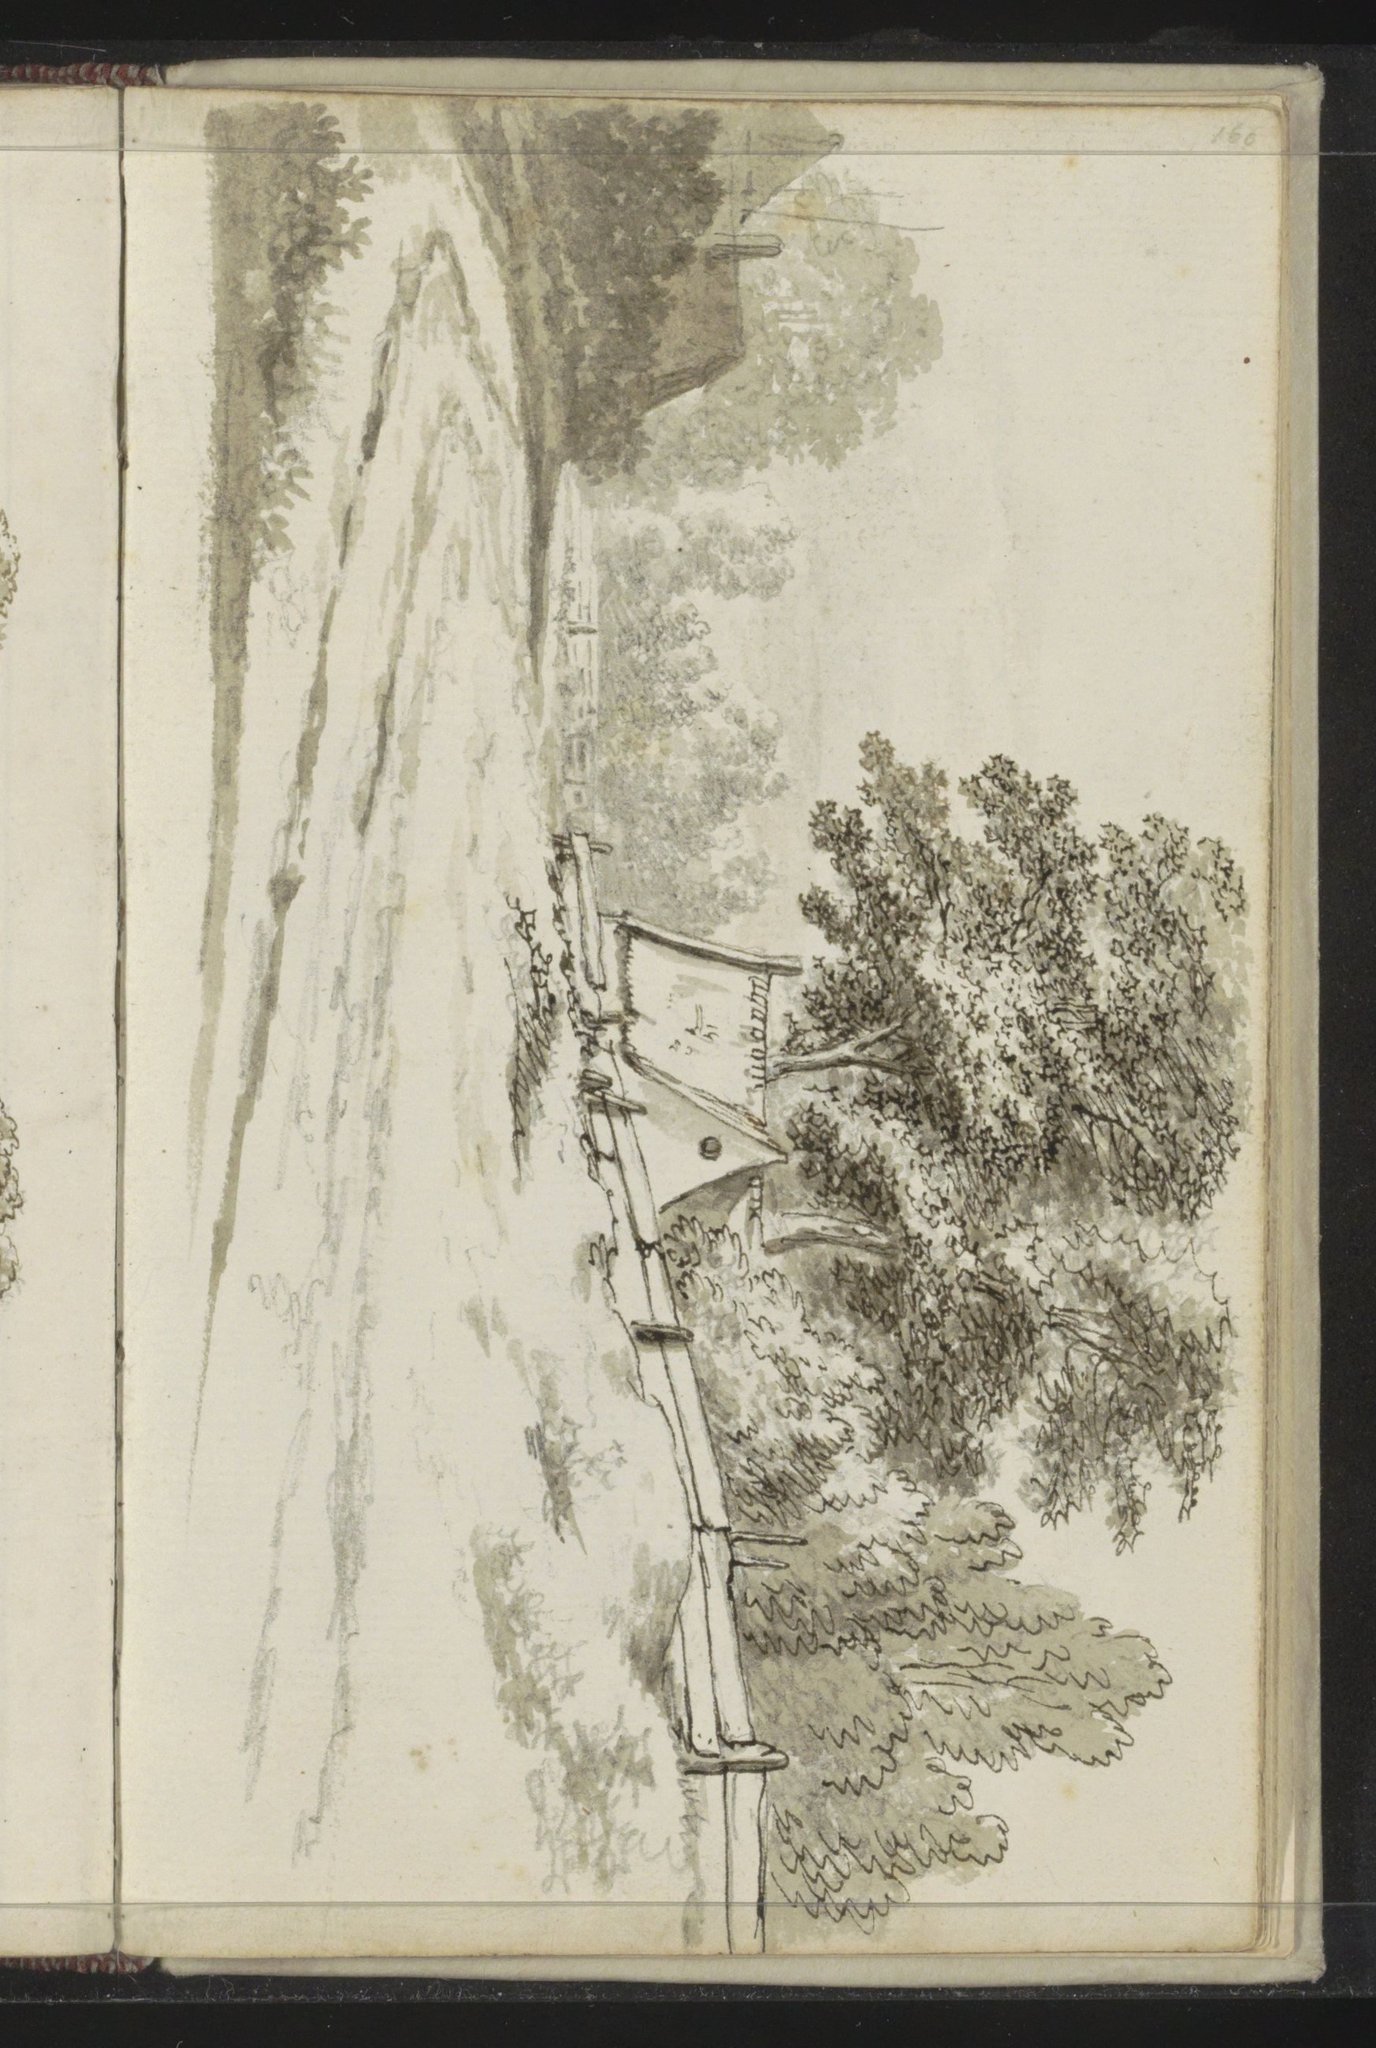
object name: sketchbook leaf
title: Huizen aan een pad in een landschap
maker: johannes huibert prins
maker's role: draughtsman, painter, print maker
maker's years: 1757-1806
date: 1783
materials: ink, paper, pencil, watercolor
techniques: brush, pen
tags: fence, wall, paling, cottage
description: Pagina 160 uit een schetsboek met 175 pagina's.